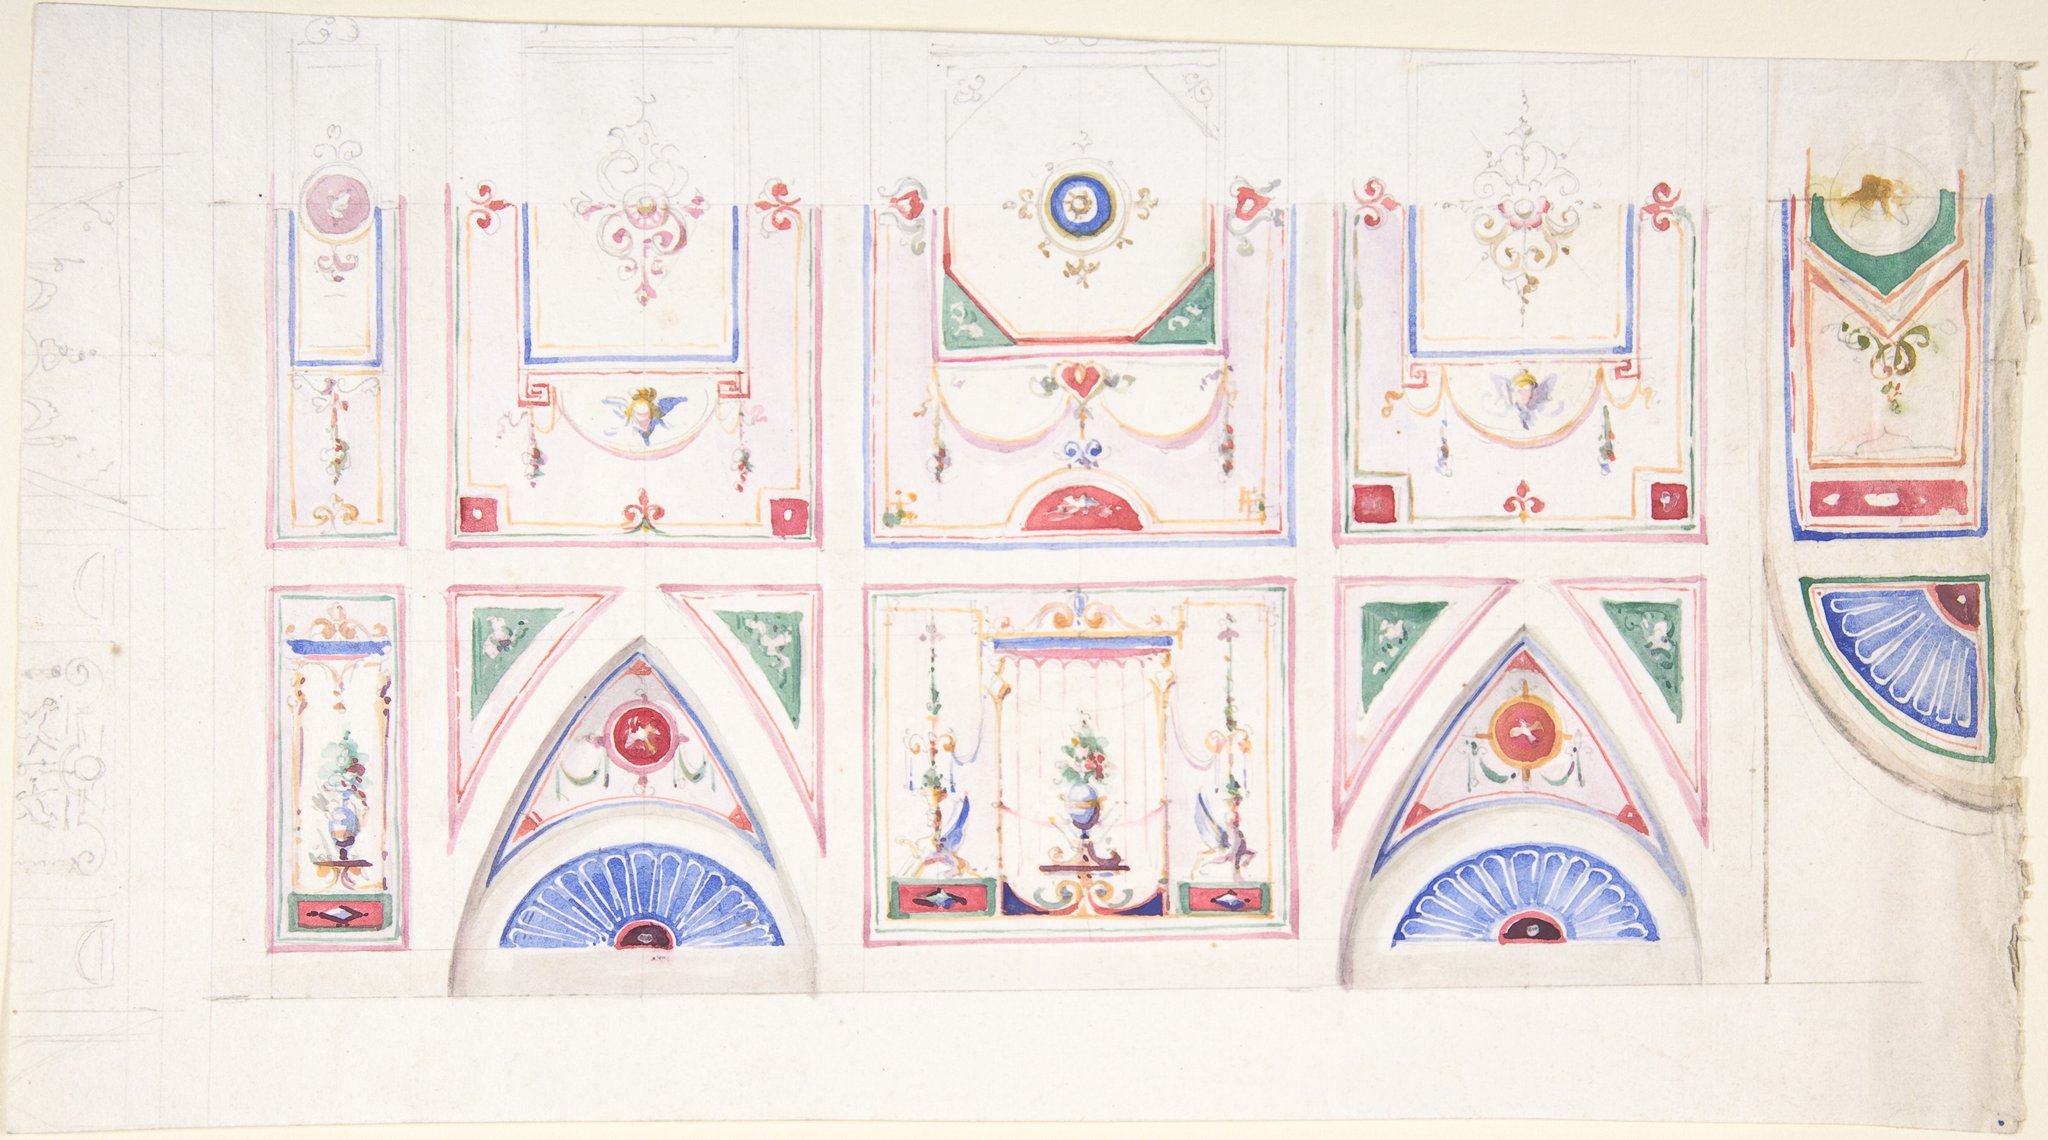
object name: drawing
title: Design for a Painted Ceiling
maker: anonymous, italian, 19th century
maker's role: artist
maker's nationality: italian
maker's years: 1800-1900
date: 1825-1875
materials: watercolor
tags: architecture